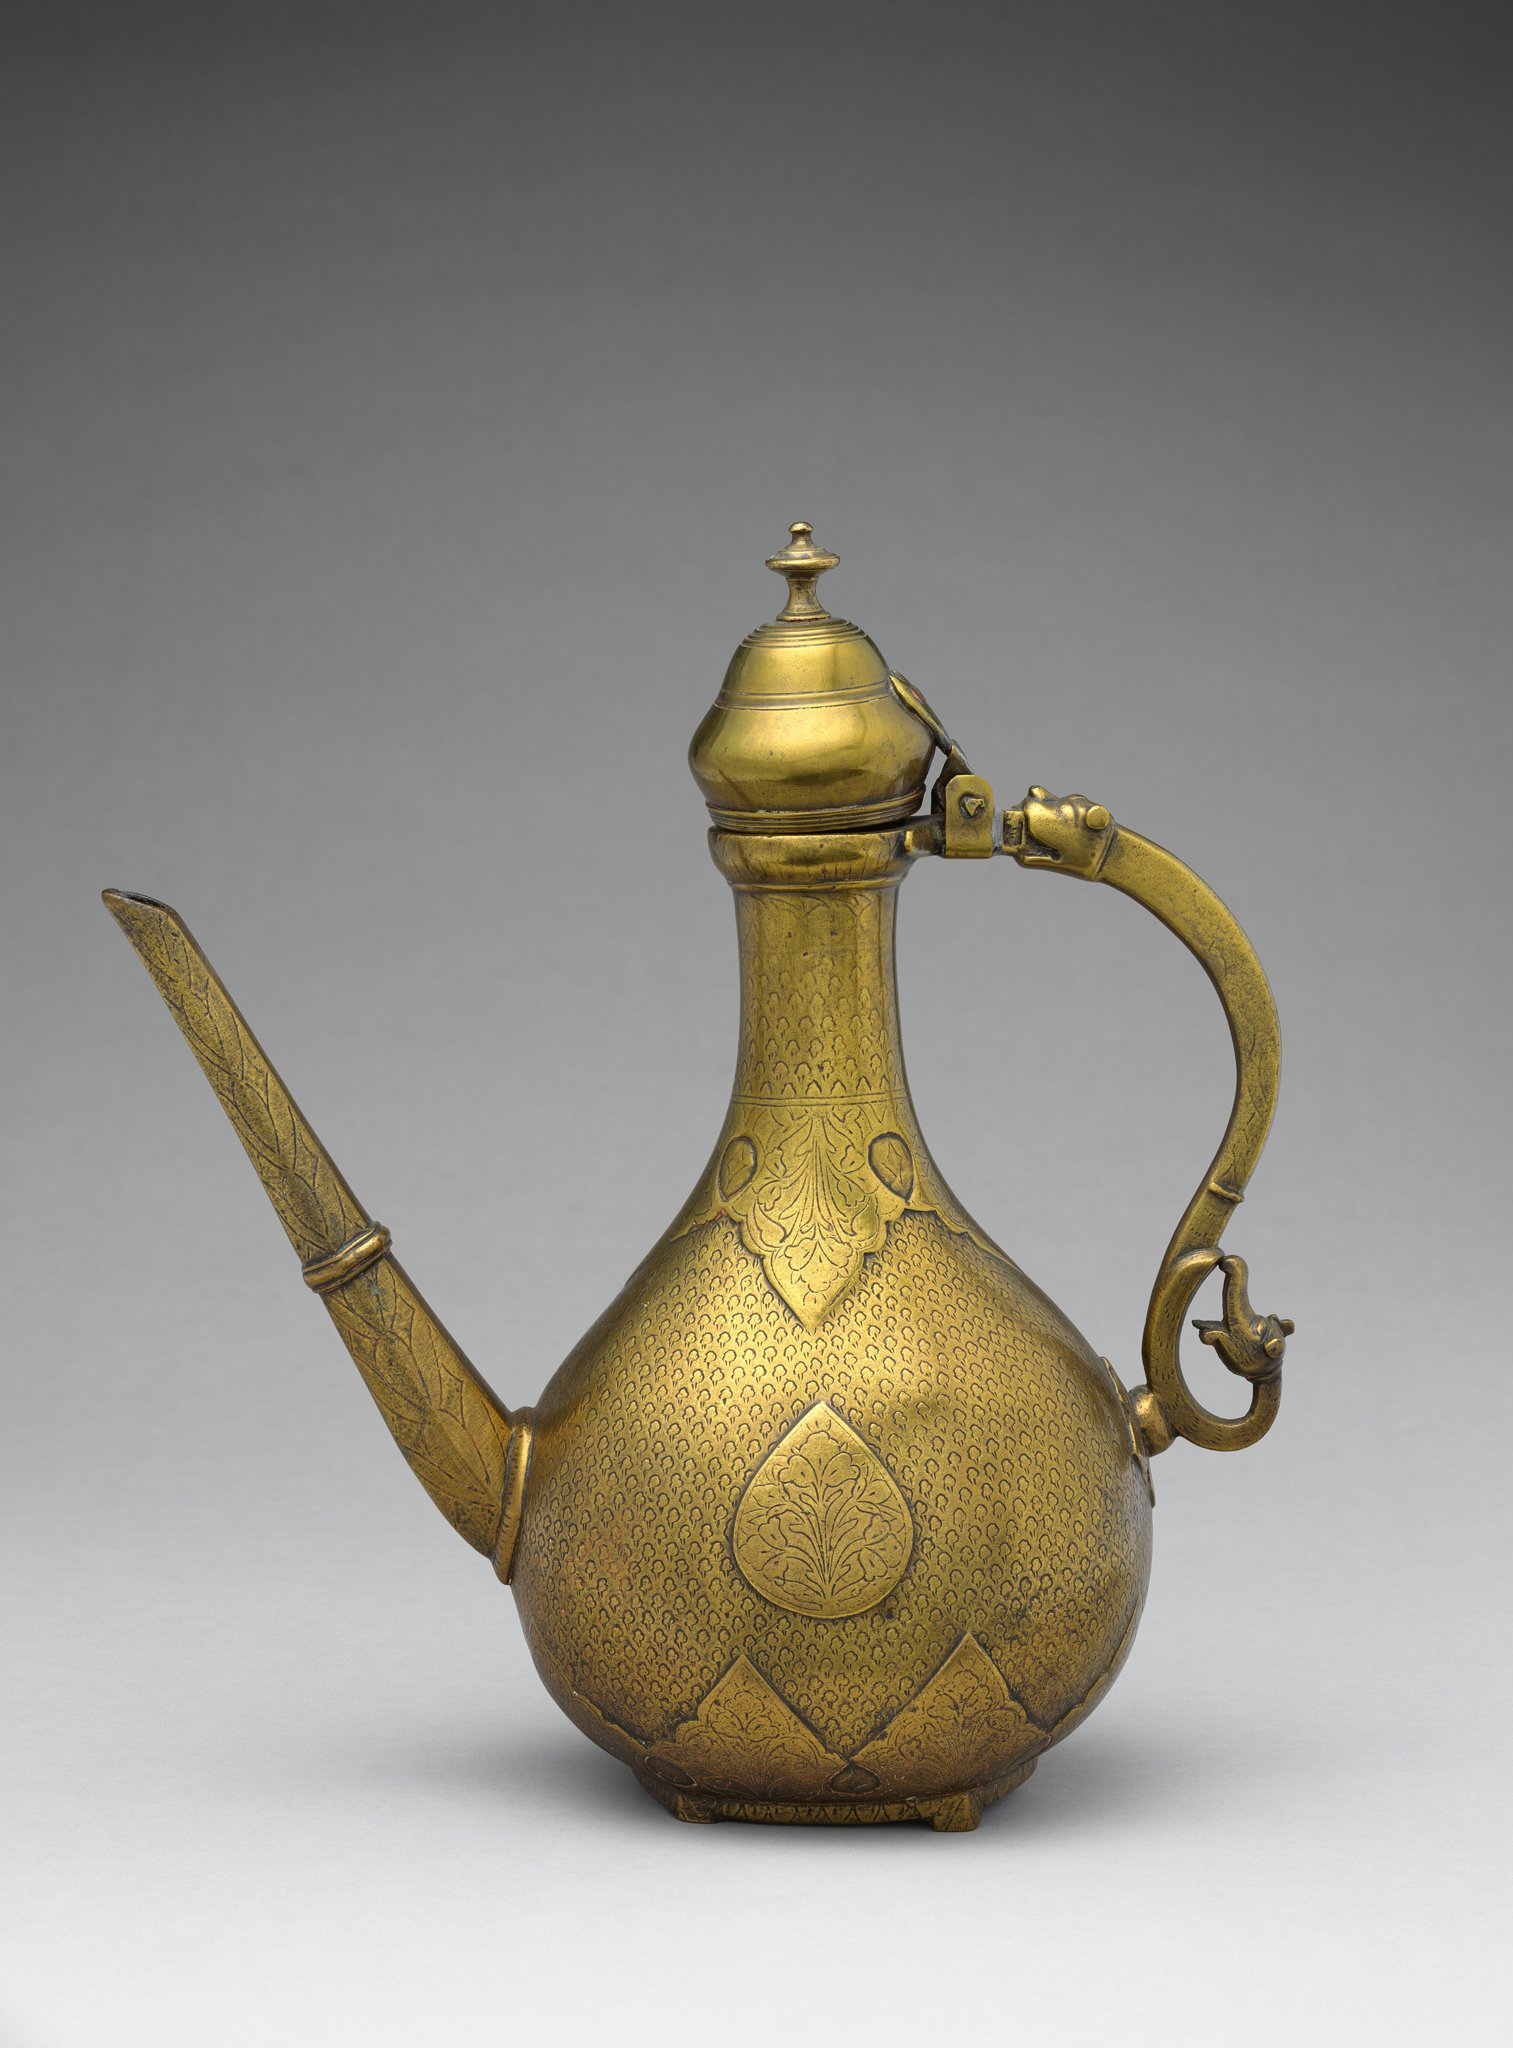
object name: ewer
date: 1701-1900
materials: brass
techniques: casting, chasing, cutting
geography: india